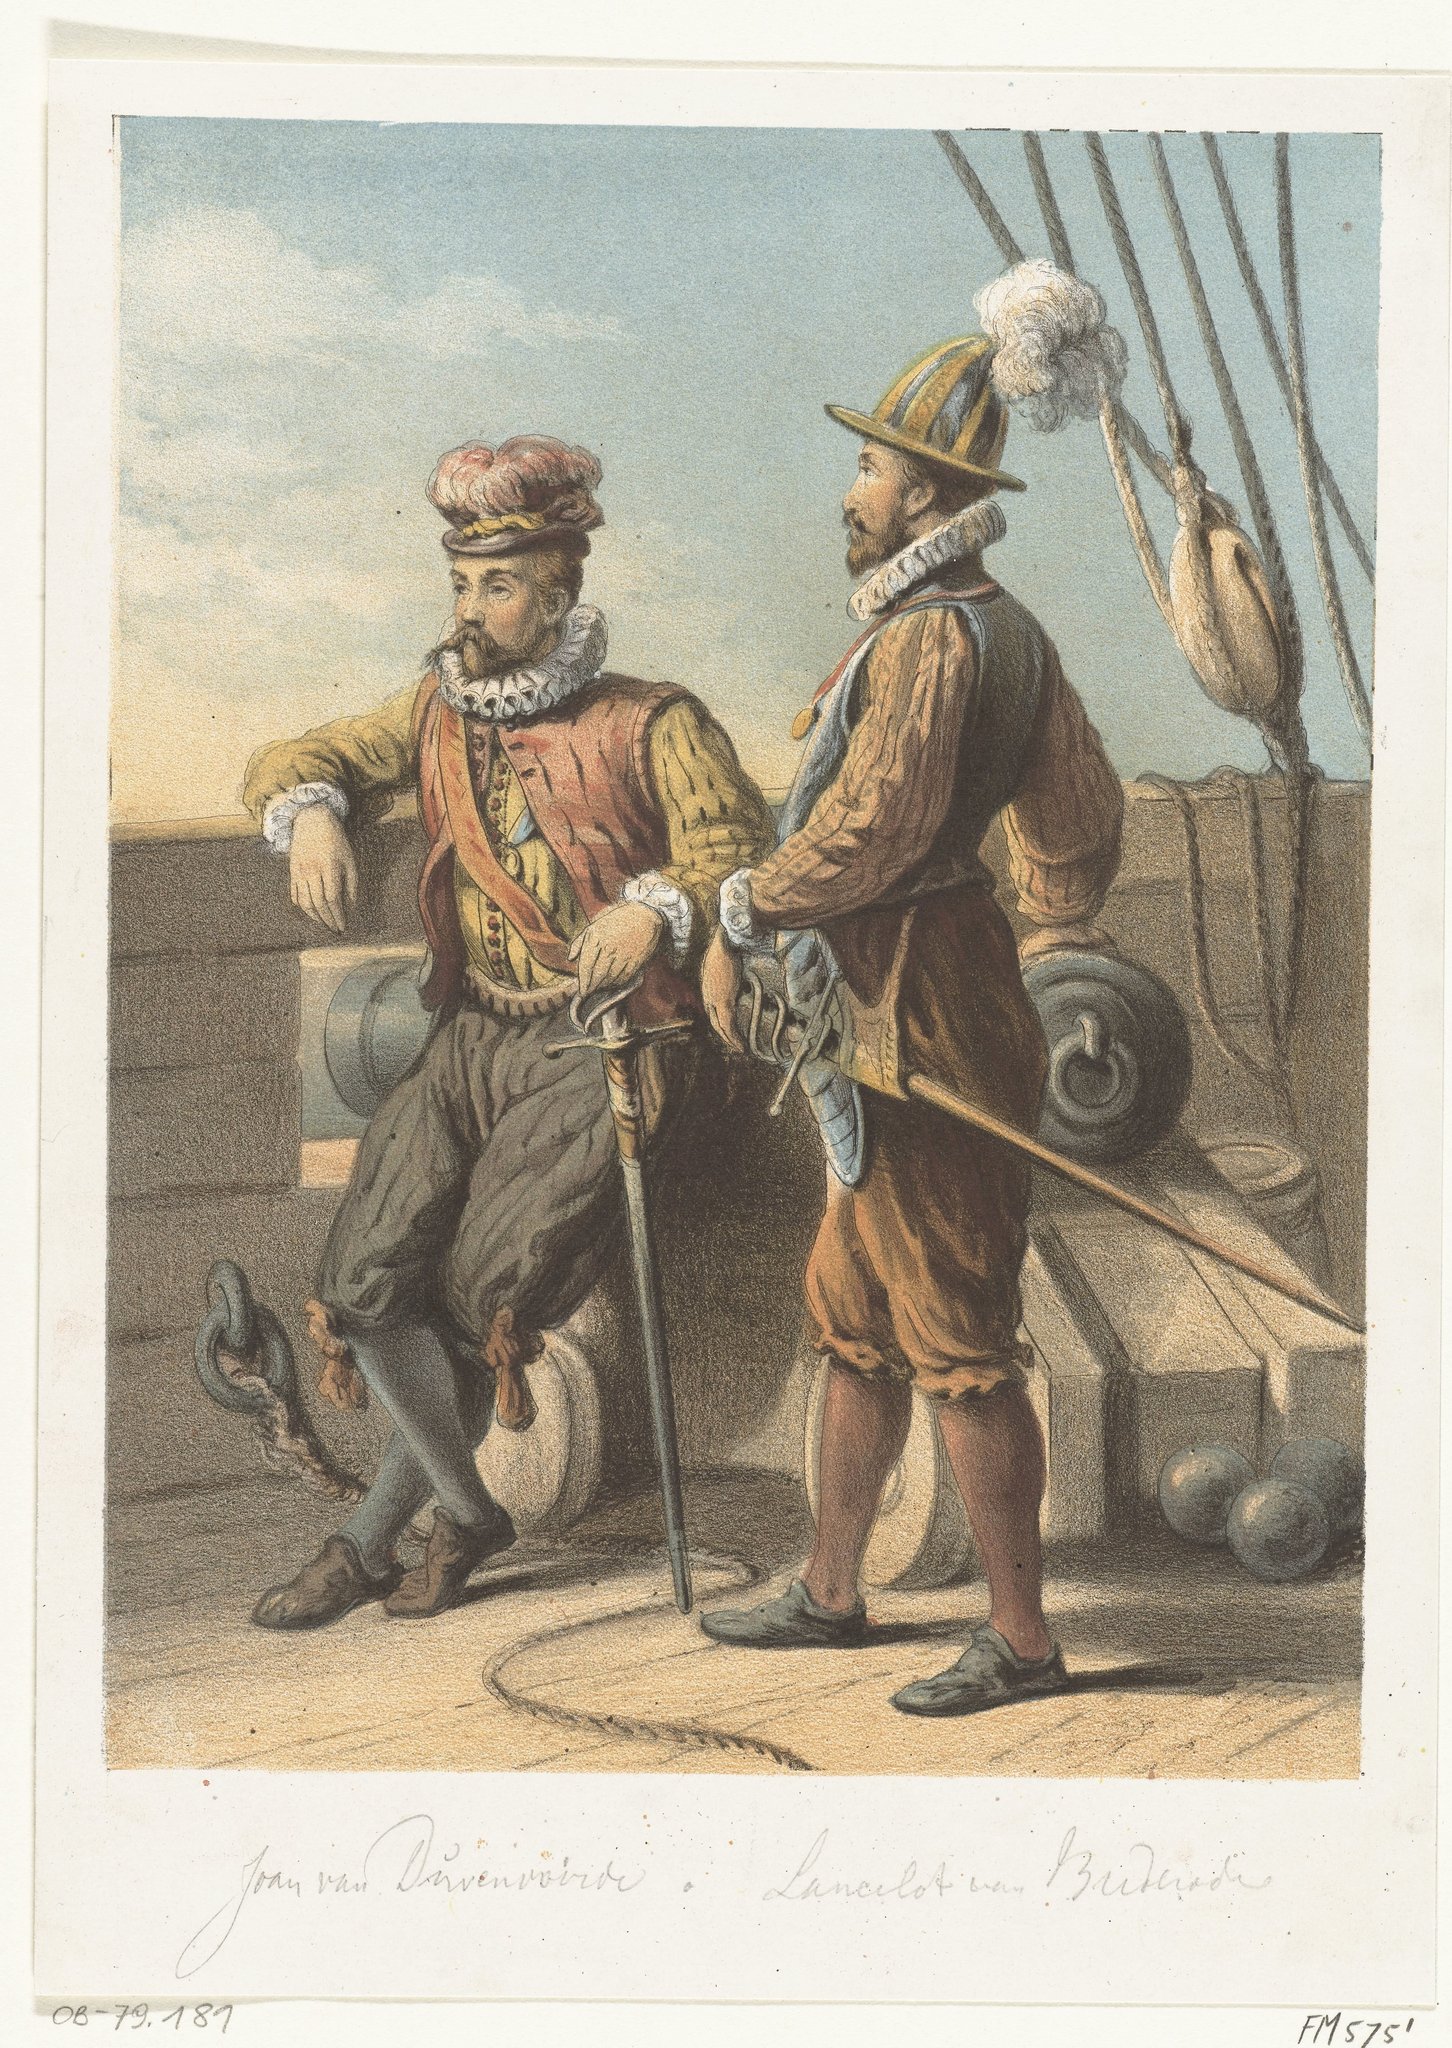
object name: print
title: Portretten van de watergeuzen Jan van Duivenvoorde en Lancelot van Brederode, 1572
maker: Anonymous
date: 1825-1899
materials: paper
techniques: chromolithography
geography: netherlands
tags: haarlem, the soldier; the soldier's life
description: Portretten van de watergeuzen Jan van Duivenvoorde en Lancelot van Brederode, op het dek van een schip bij een kanon, 1572.